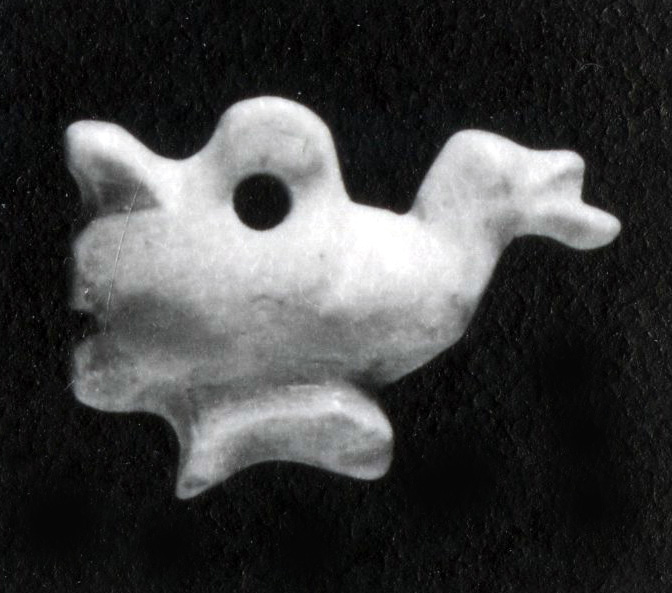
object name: amulet, duck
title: Duckling amulet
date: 2110-2030 BCE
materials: ivory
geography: egypt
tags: ducks